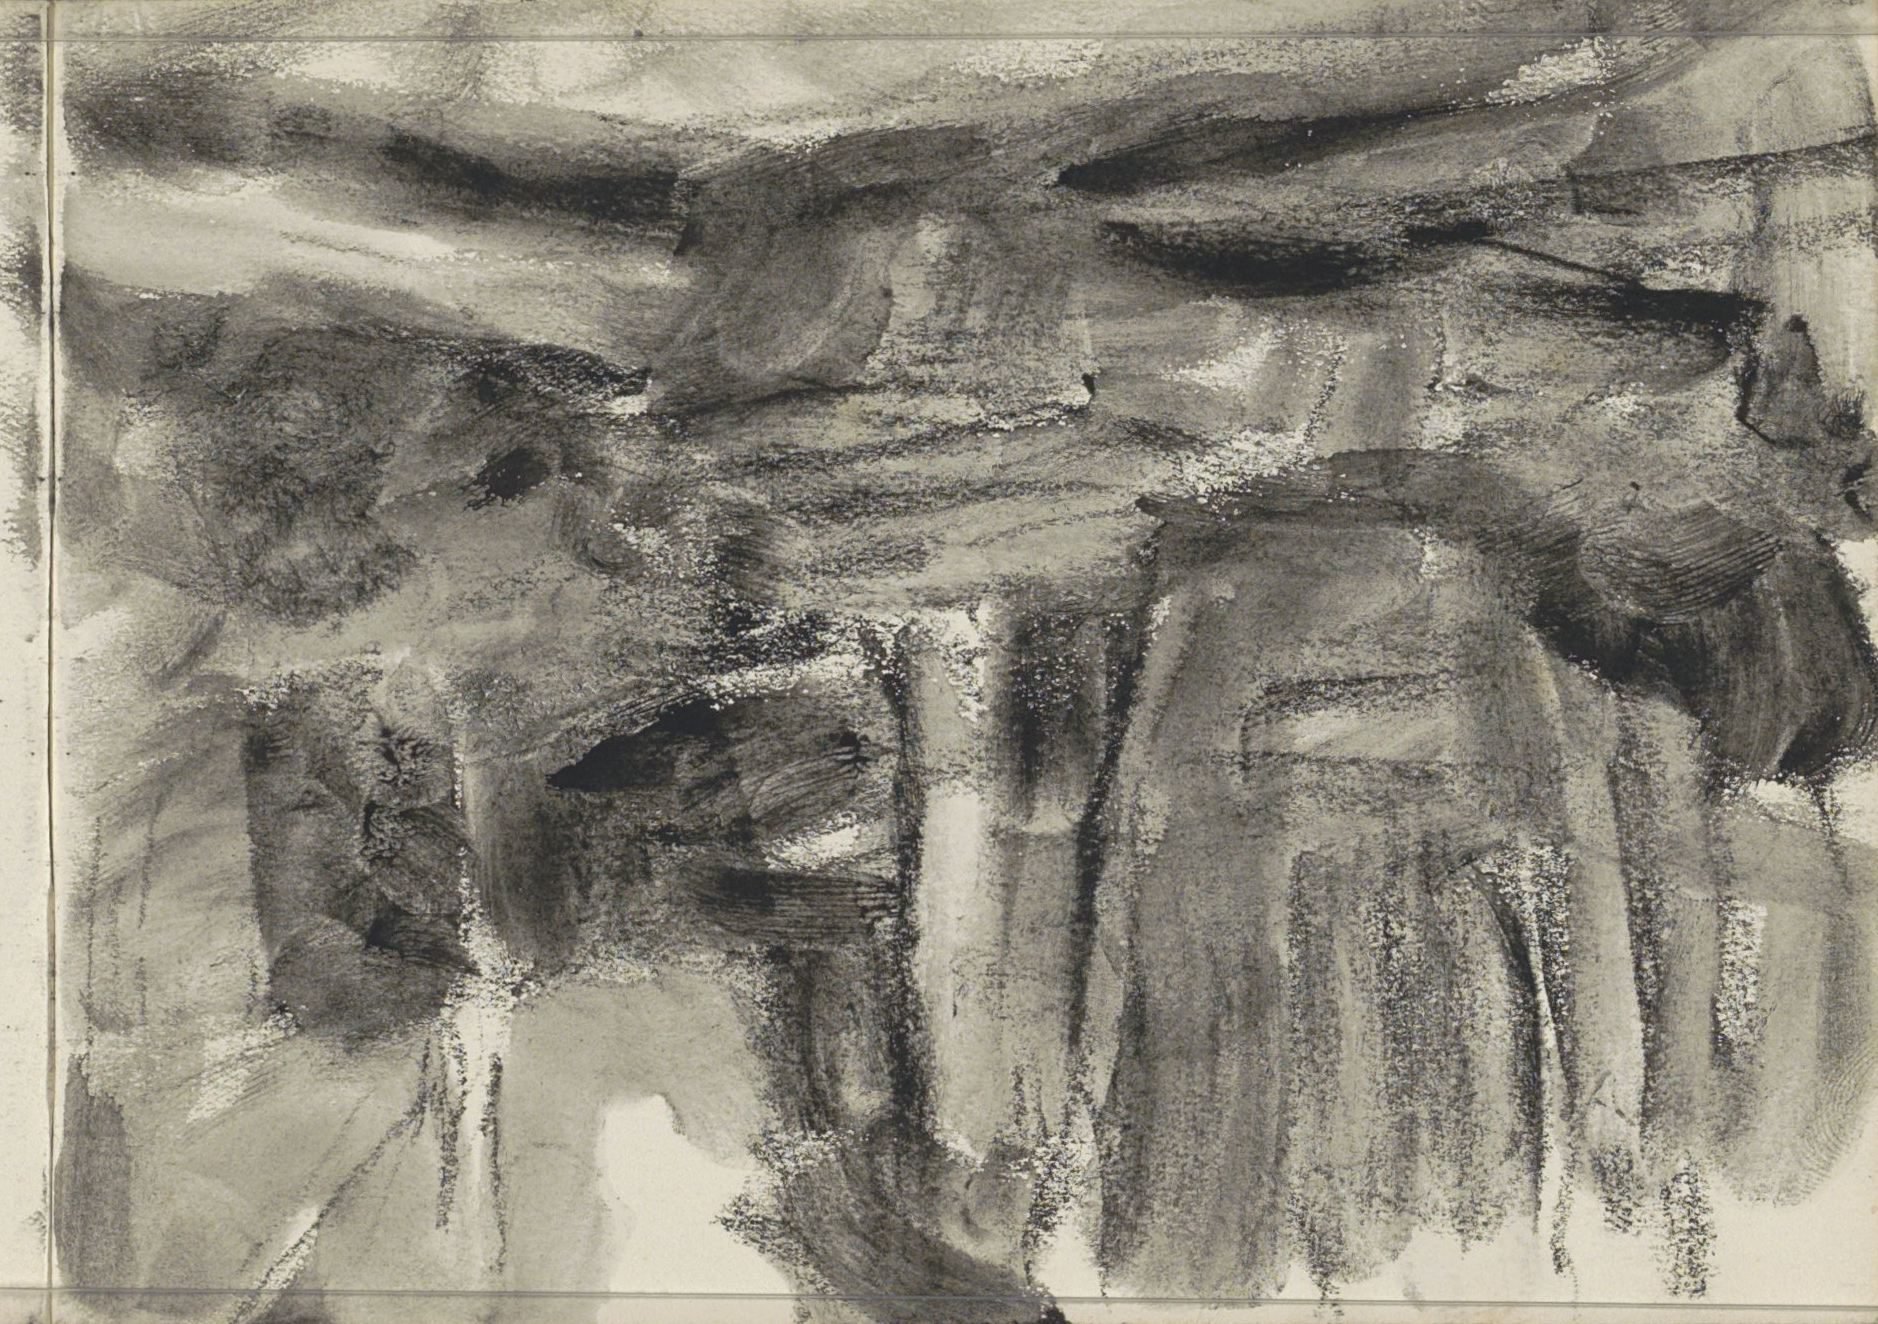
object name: sketchbook leaf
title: Bosgezicht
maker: johan antonie de jonge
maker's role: draughtsman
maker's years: 1864-1927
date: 1920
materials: chalk, paper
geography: south holland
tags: forest, wood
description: Bosgezicht. Blad 2 recto uit een schetsboek met 21 bladen.